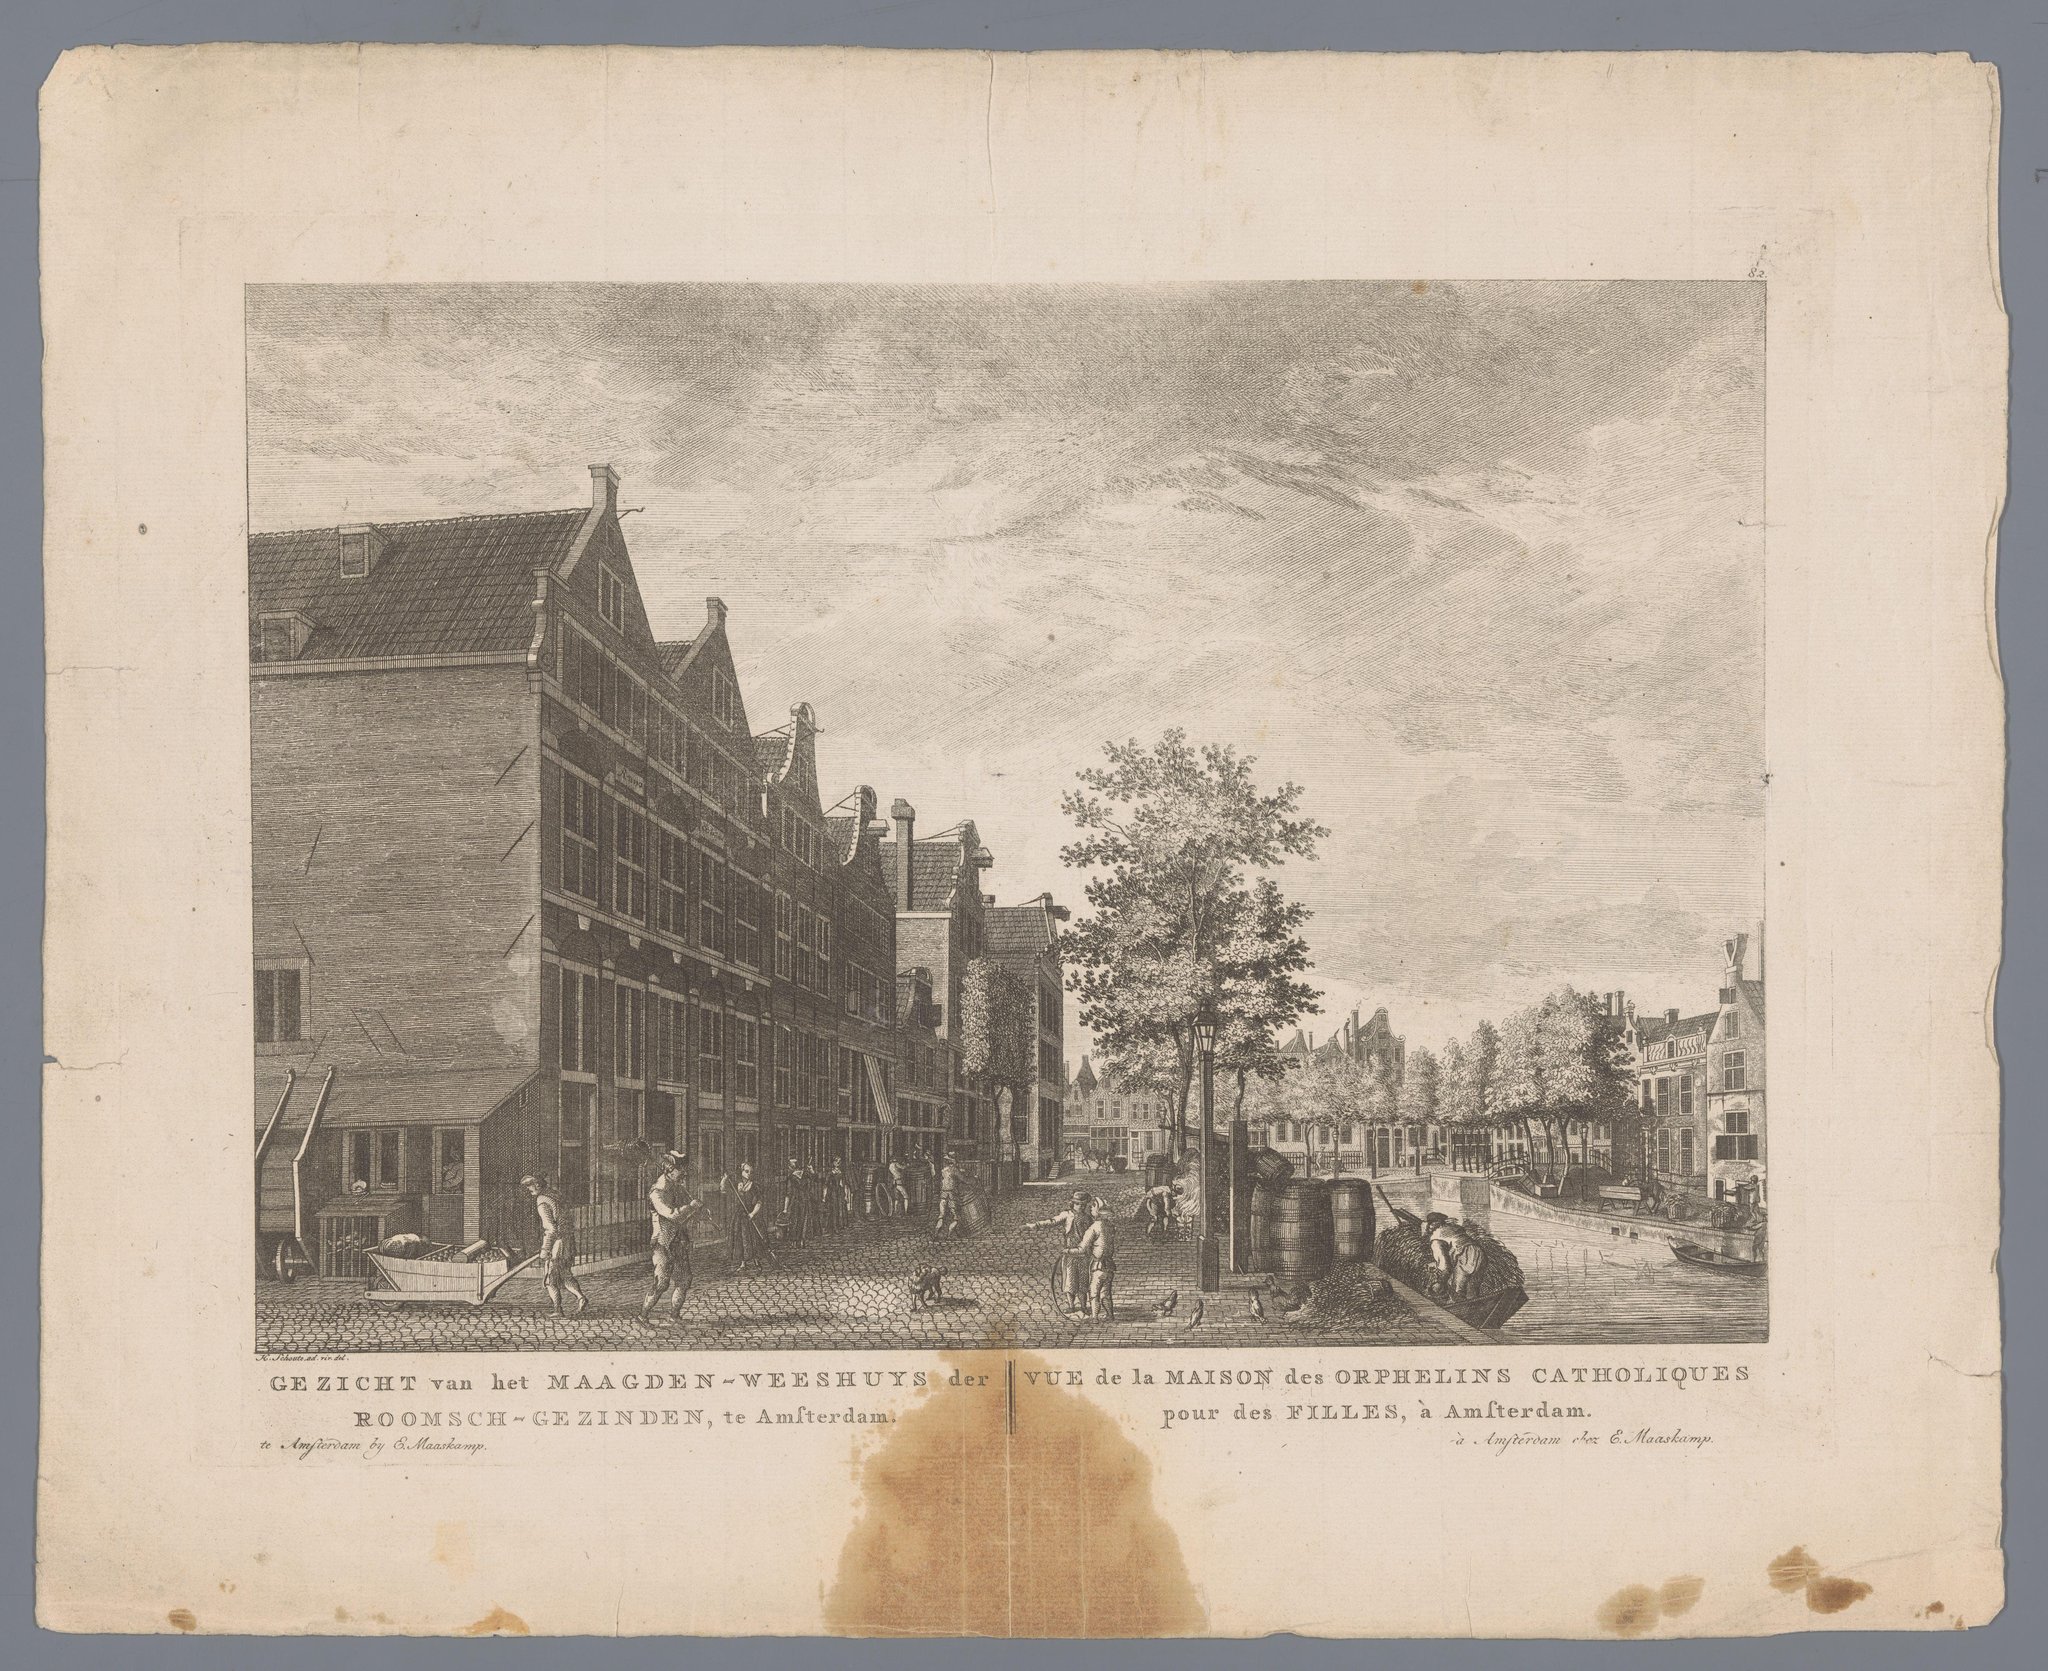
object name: print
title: Gezicht op het rooms-katholieke Maagdenhuis te Amsterdam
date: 1805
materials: paper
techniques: engraving, etching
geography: amsterdam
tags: orphanage, bridge in city across river, canal, etc.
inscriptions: collector's mark: Lugt 2228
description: Prent uit de door Maaskamp uitgegeven editie van de Atlas Fouquet: Nieuwe atlas, van de voornaamste gebouwen en gezigten der stad Amsterdam. Met derzelver beknopte beschryvingen. Amsterdam: Evert Maaskamp, 1805. Eerder is deze prent ook gebruikt in: Afbeeldingen van de wyd-vermaarde koopstad Amsterdam benevens des zelvs voornaamste gebouwen en gezigten alle naar het leeven getekend / Receuil des edifices les plus considerables et des plus belles vues, de la fameuse ville d'Amsterdam, dessinées d'après nature. Amsterdam: Pierre Fouquet, 1778-1783. En: Nieuwe atlas, van de voornaamste gebouwen en gezigten der stad Amsterdam, met derzelver beknopte beschryvingen. 2 dln. Amsterdam: Daniël Jean Changuion en Petrus den Hengst [in opdracht van Pierre Fouquet], 1783.